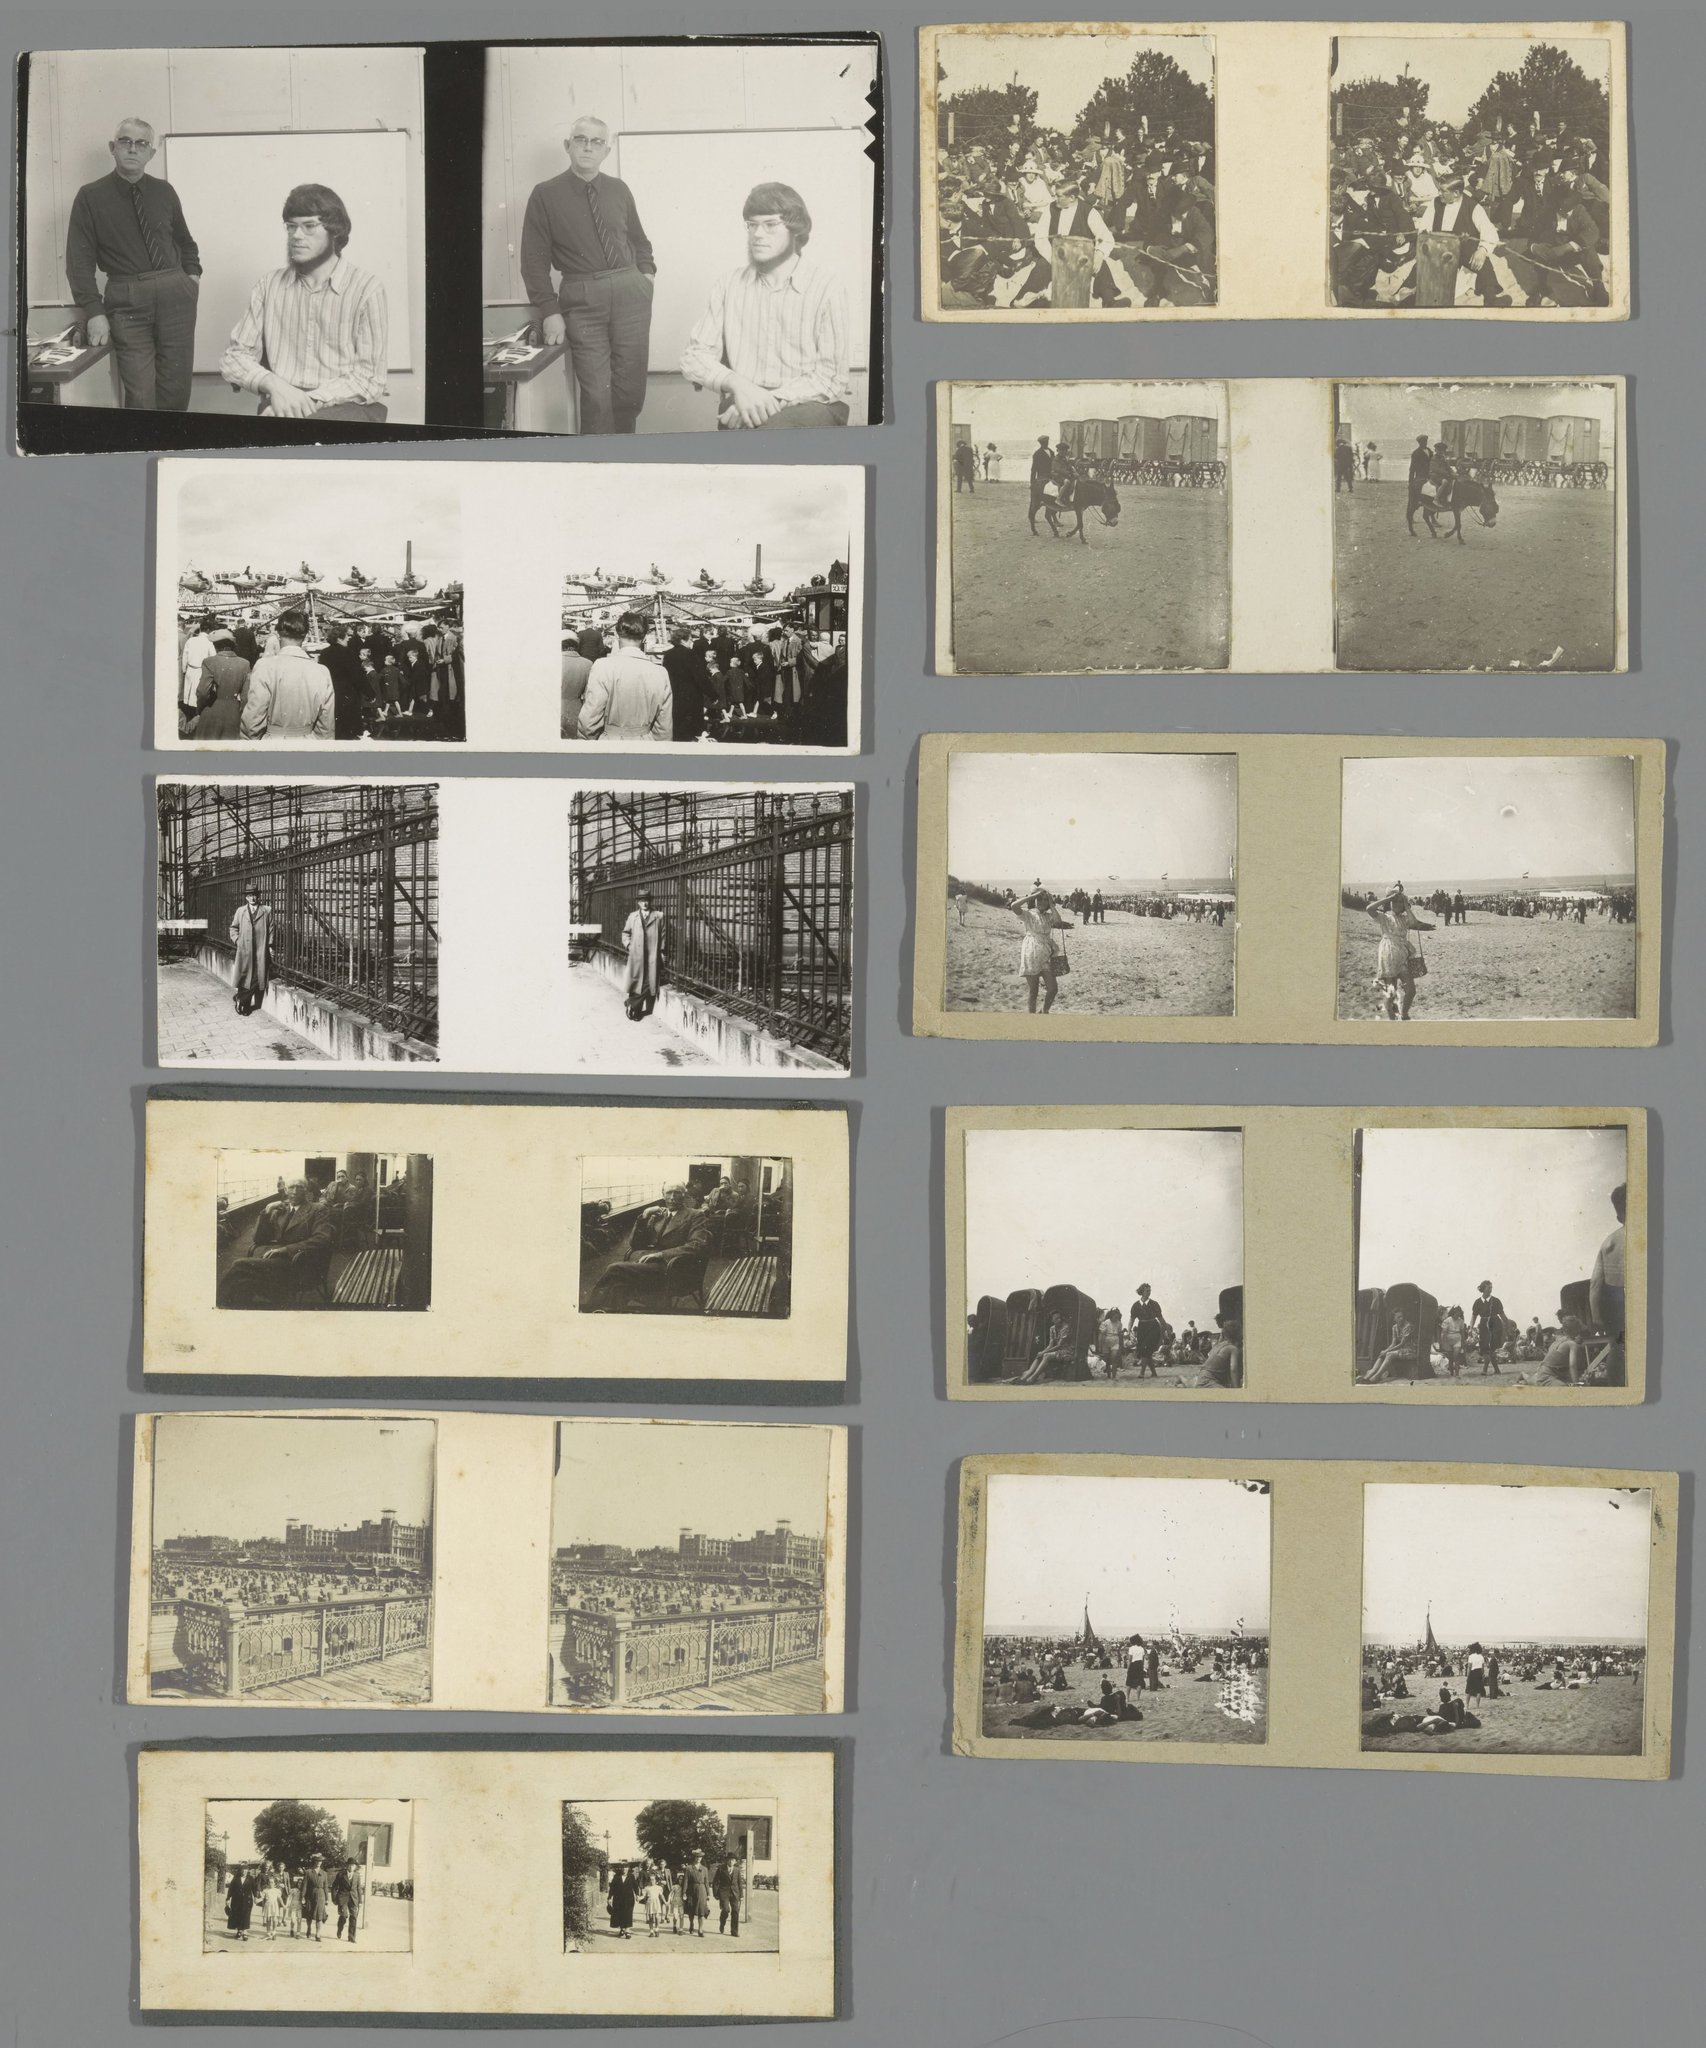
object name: stereograph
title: Strandscènes, straattaferelen en een zelfportret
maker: h.h. andrée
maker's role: amateurfotograaf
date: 1925-1935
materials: paper, cardboard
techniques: gelatin silver print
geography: netherlands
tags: h.h. andrée, beach (as place of recreation), city-view in general; 'veduta', portrait, self-portrait of photographer